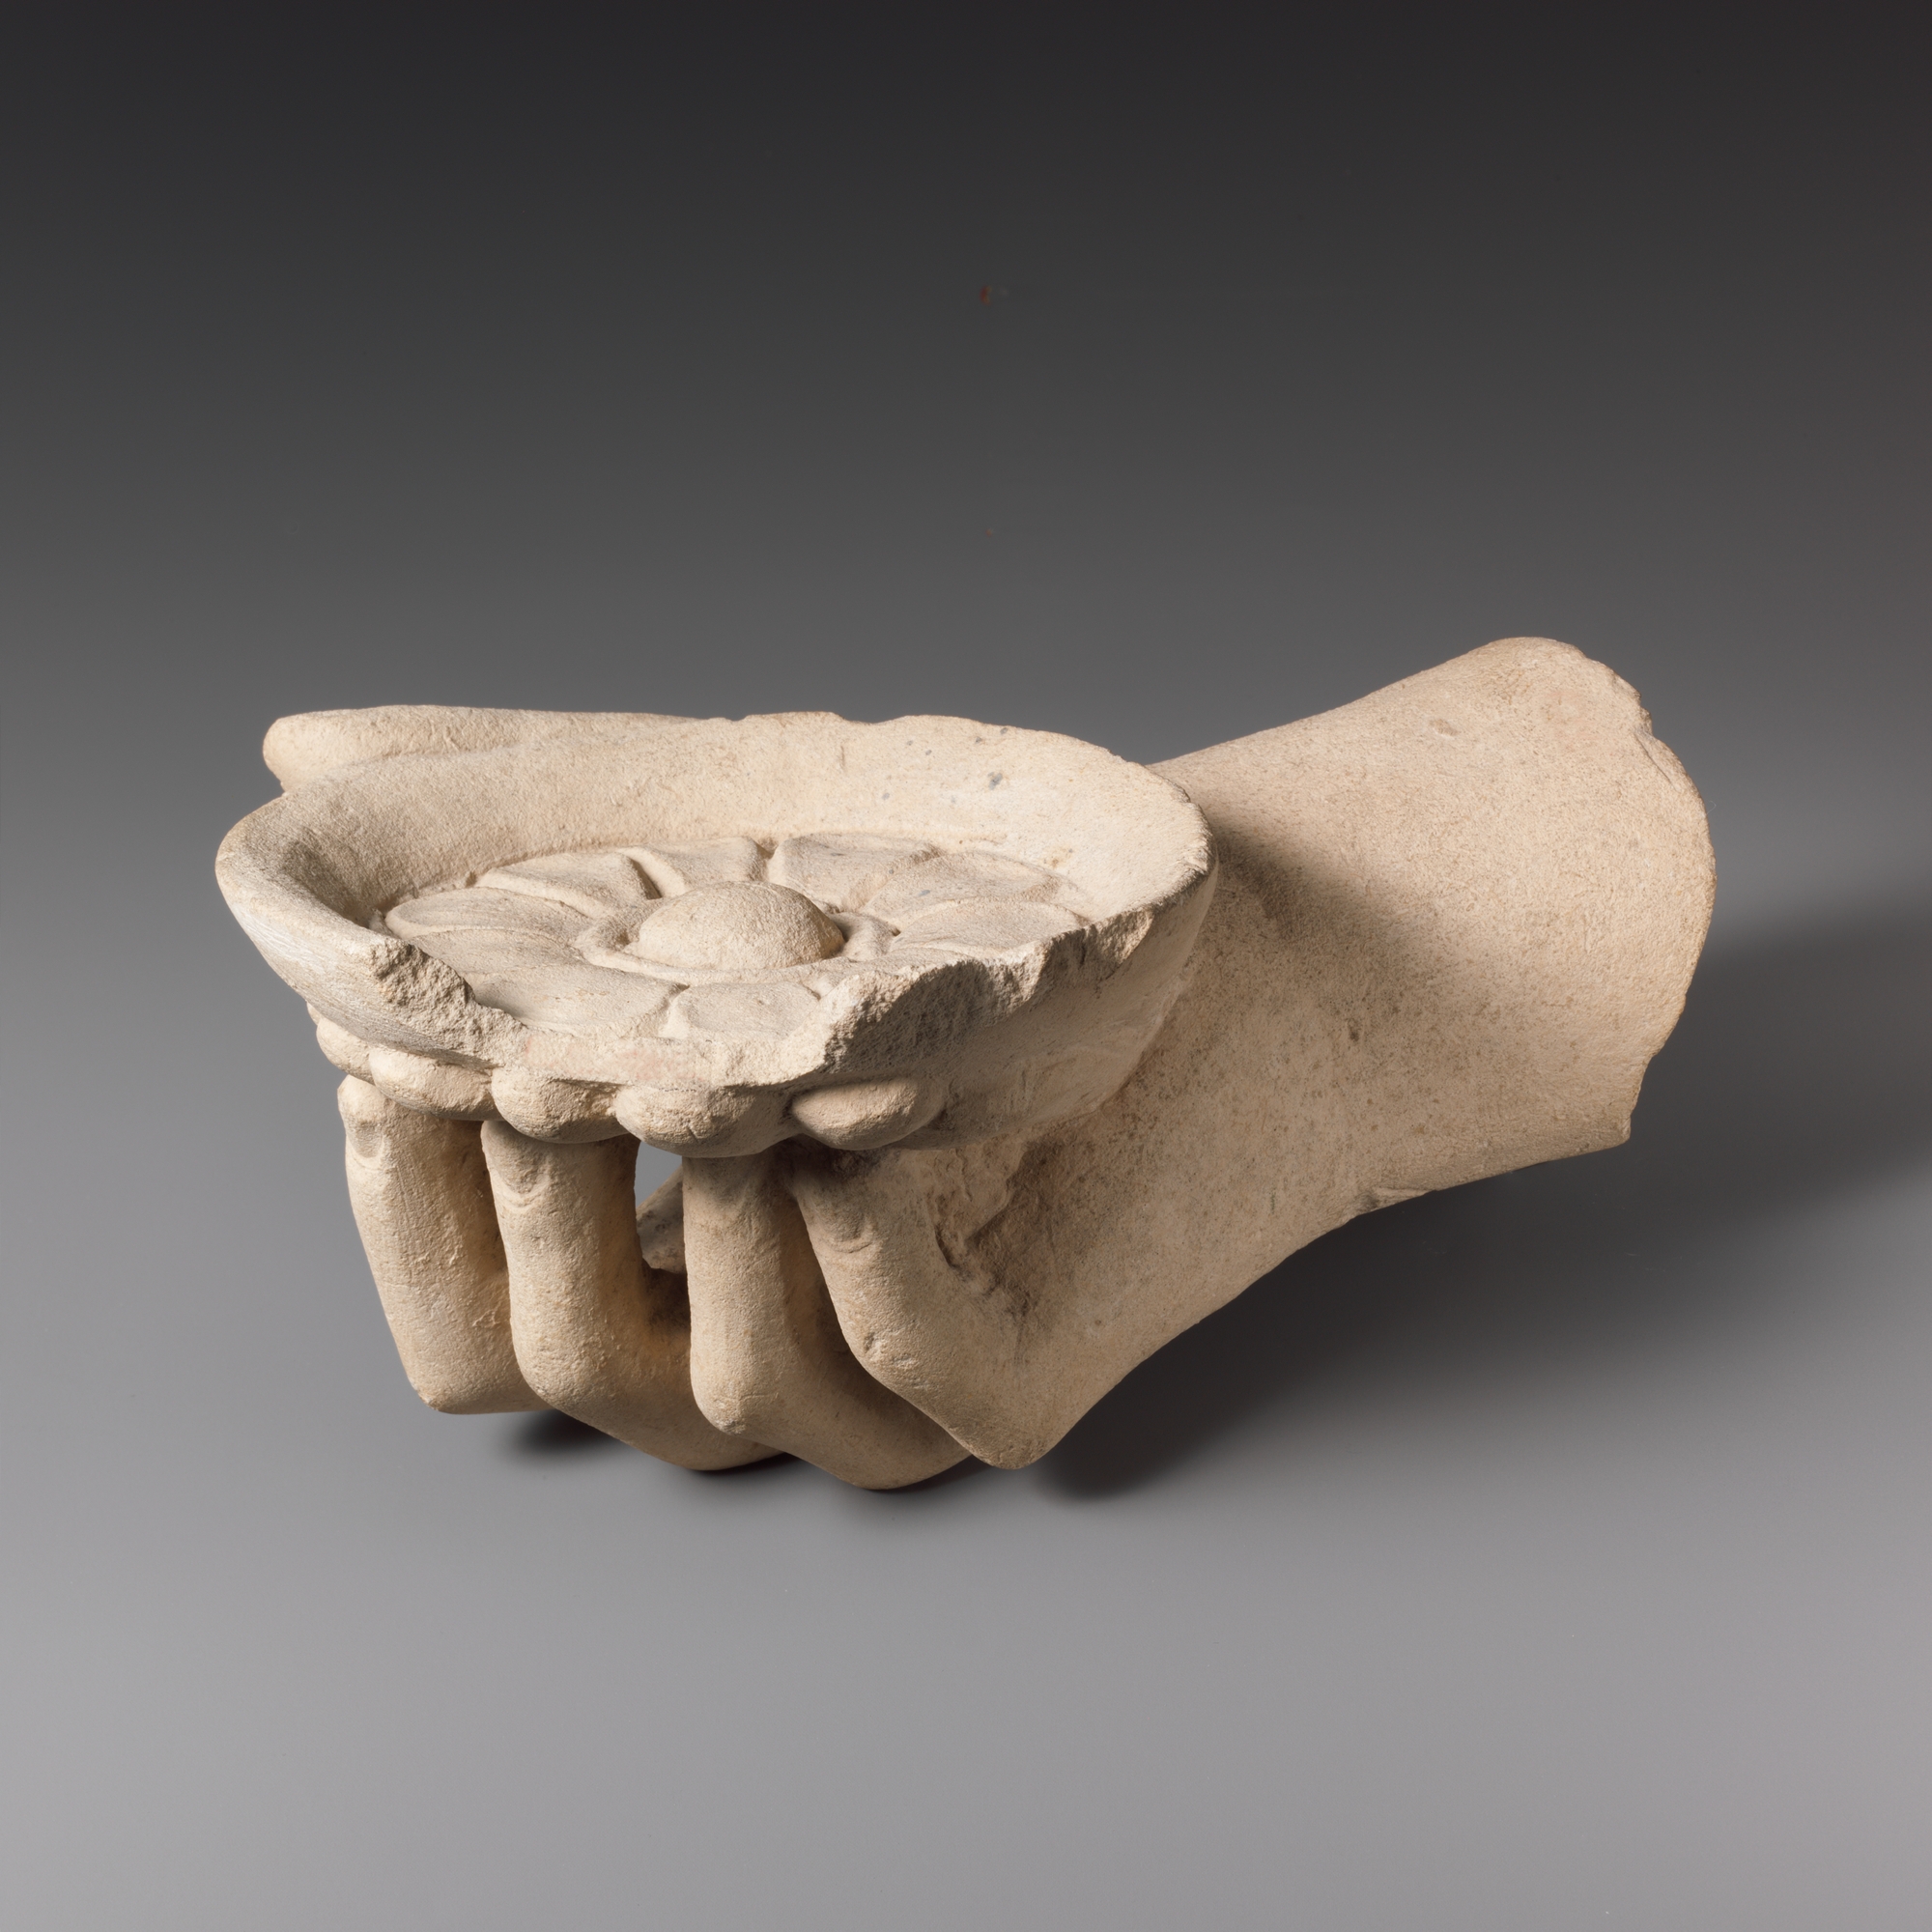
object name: hand, right, holding libation bowl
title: Limestone hand holding a phiale (libation bowl)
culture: cypriot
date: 500-301 BCE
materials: limestone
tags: hands